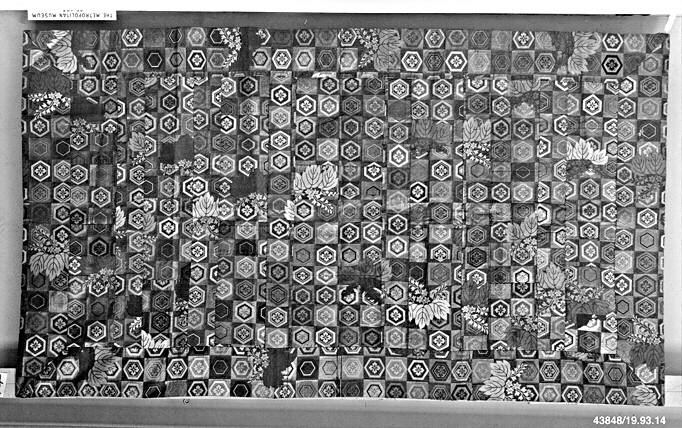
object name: robe, priest's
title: Priest's Robe (Shichijō)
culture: japanese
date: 1596-1615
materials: silk